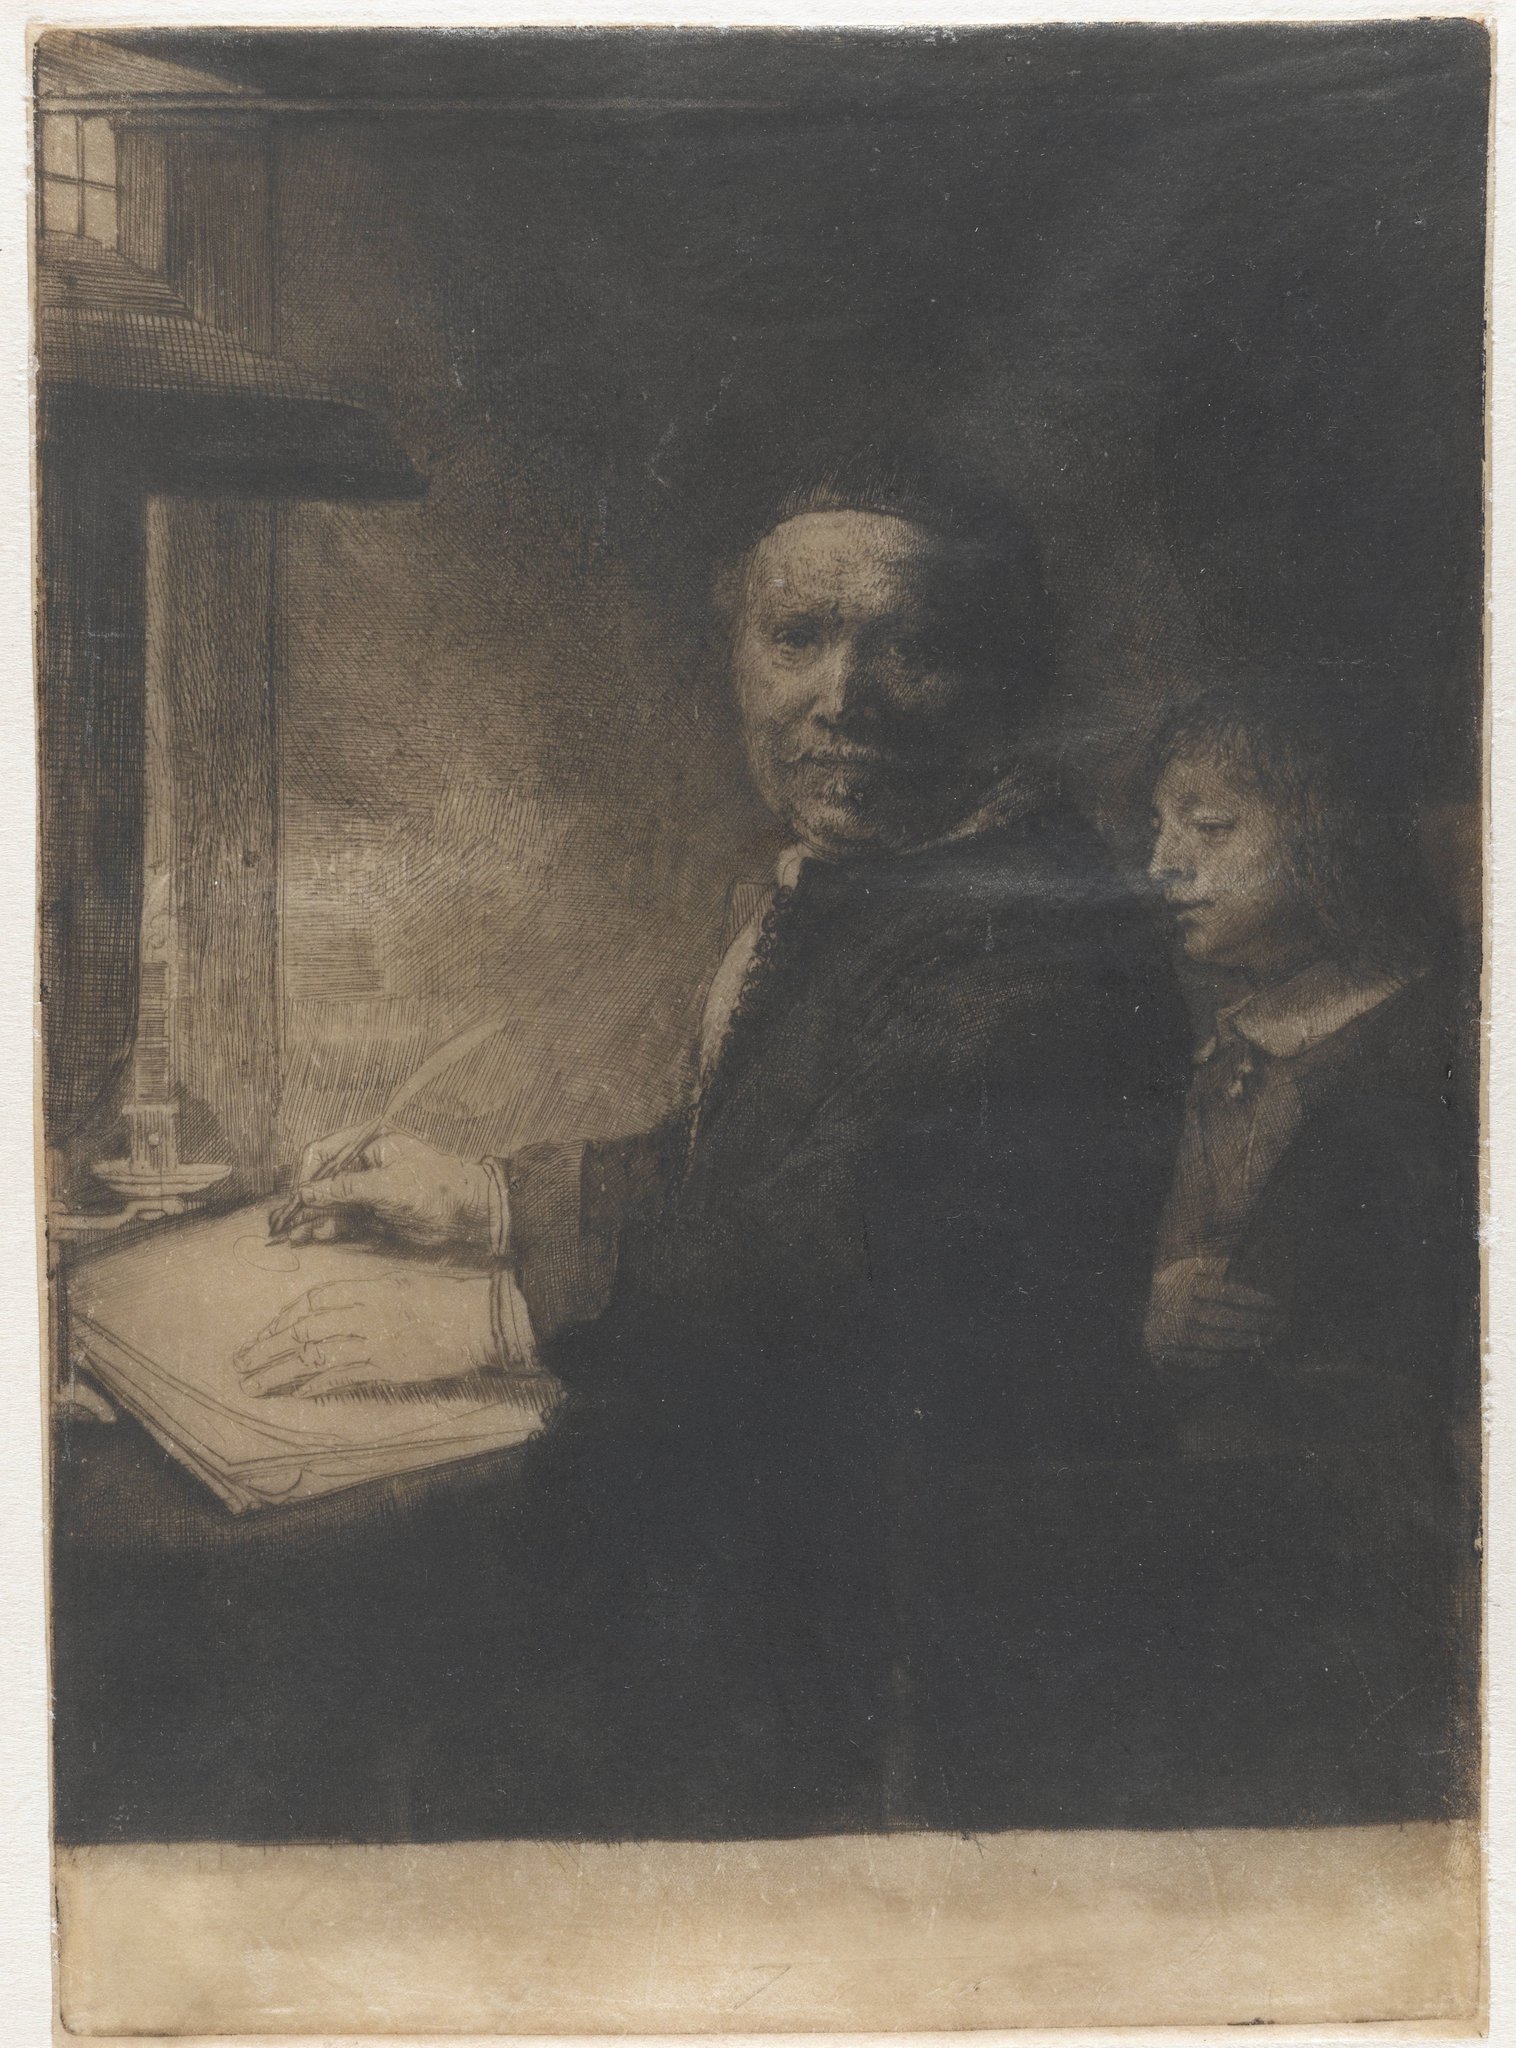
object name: print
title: Lieven Willemsz. van Coppenol, writing master: the smaller plate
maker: rembrandt van rijn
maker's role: draughtsman, painter, print maker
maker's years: 1606-1669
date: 1658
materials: parchment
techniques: drypoint, etching, intaglio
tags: amsterdam, draughtsman, lieven willemsz. coppenol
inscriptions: mark: Lugt 2228